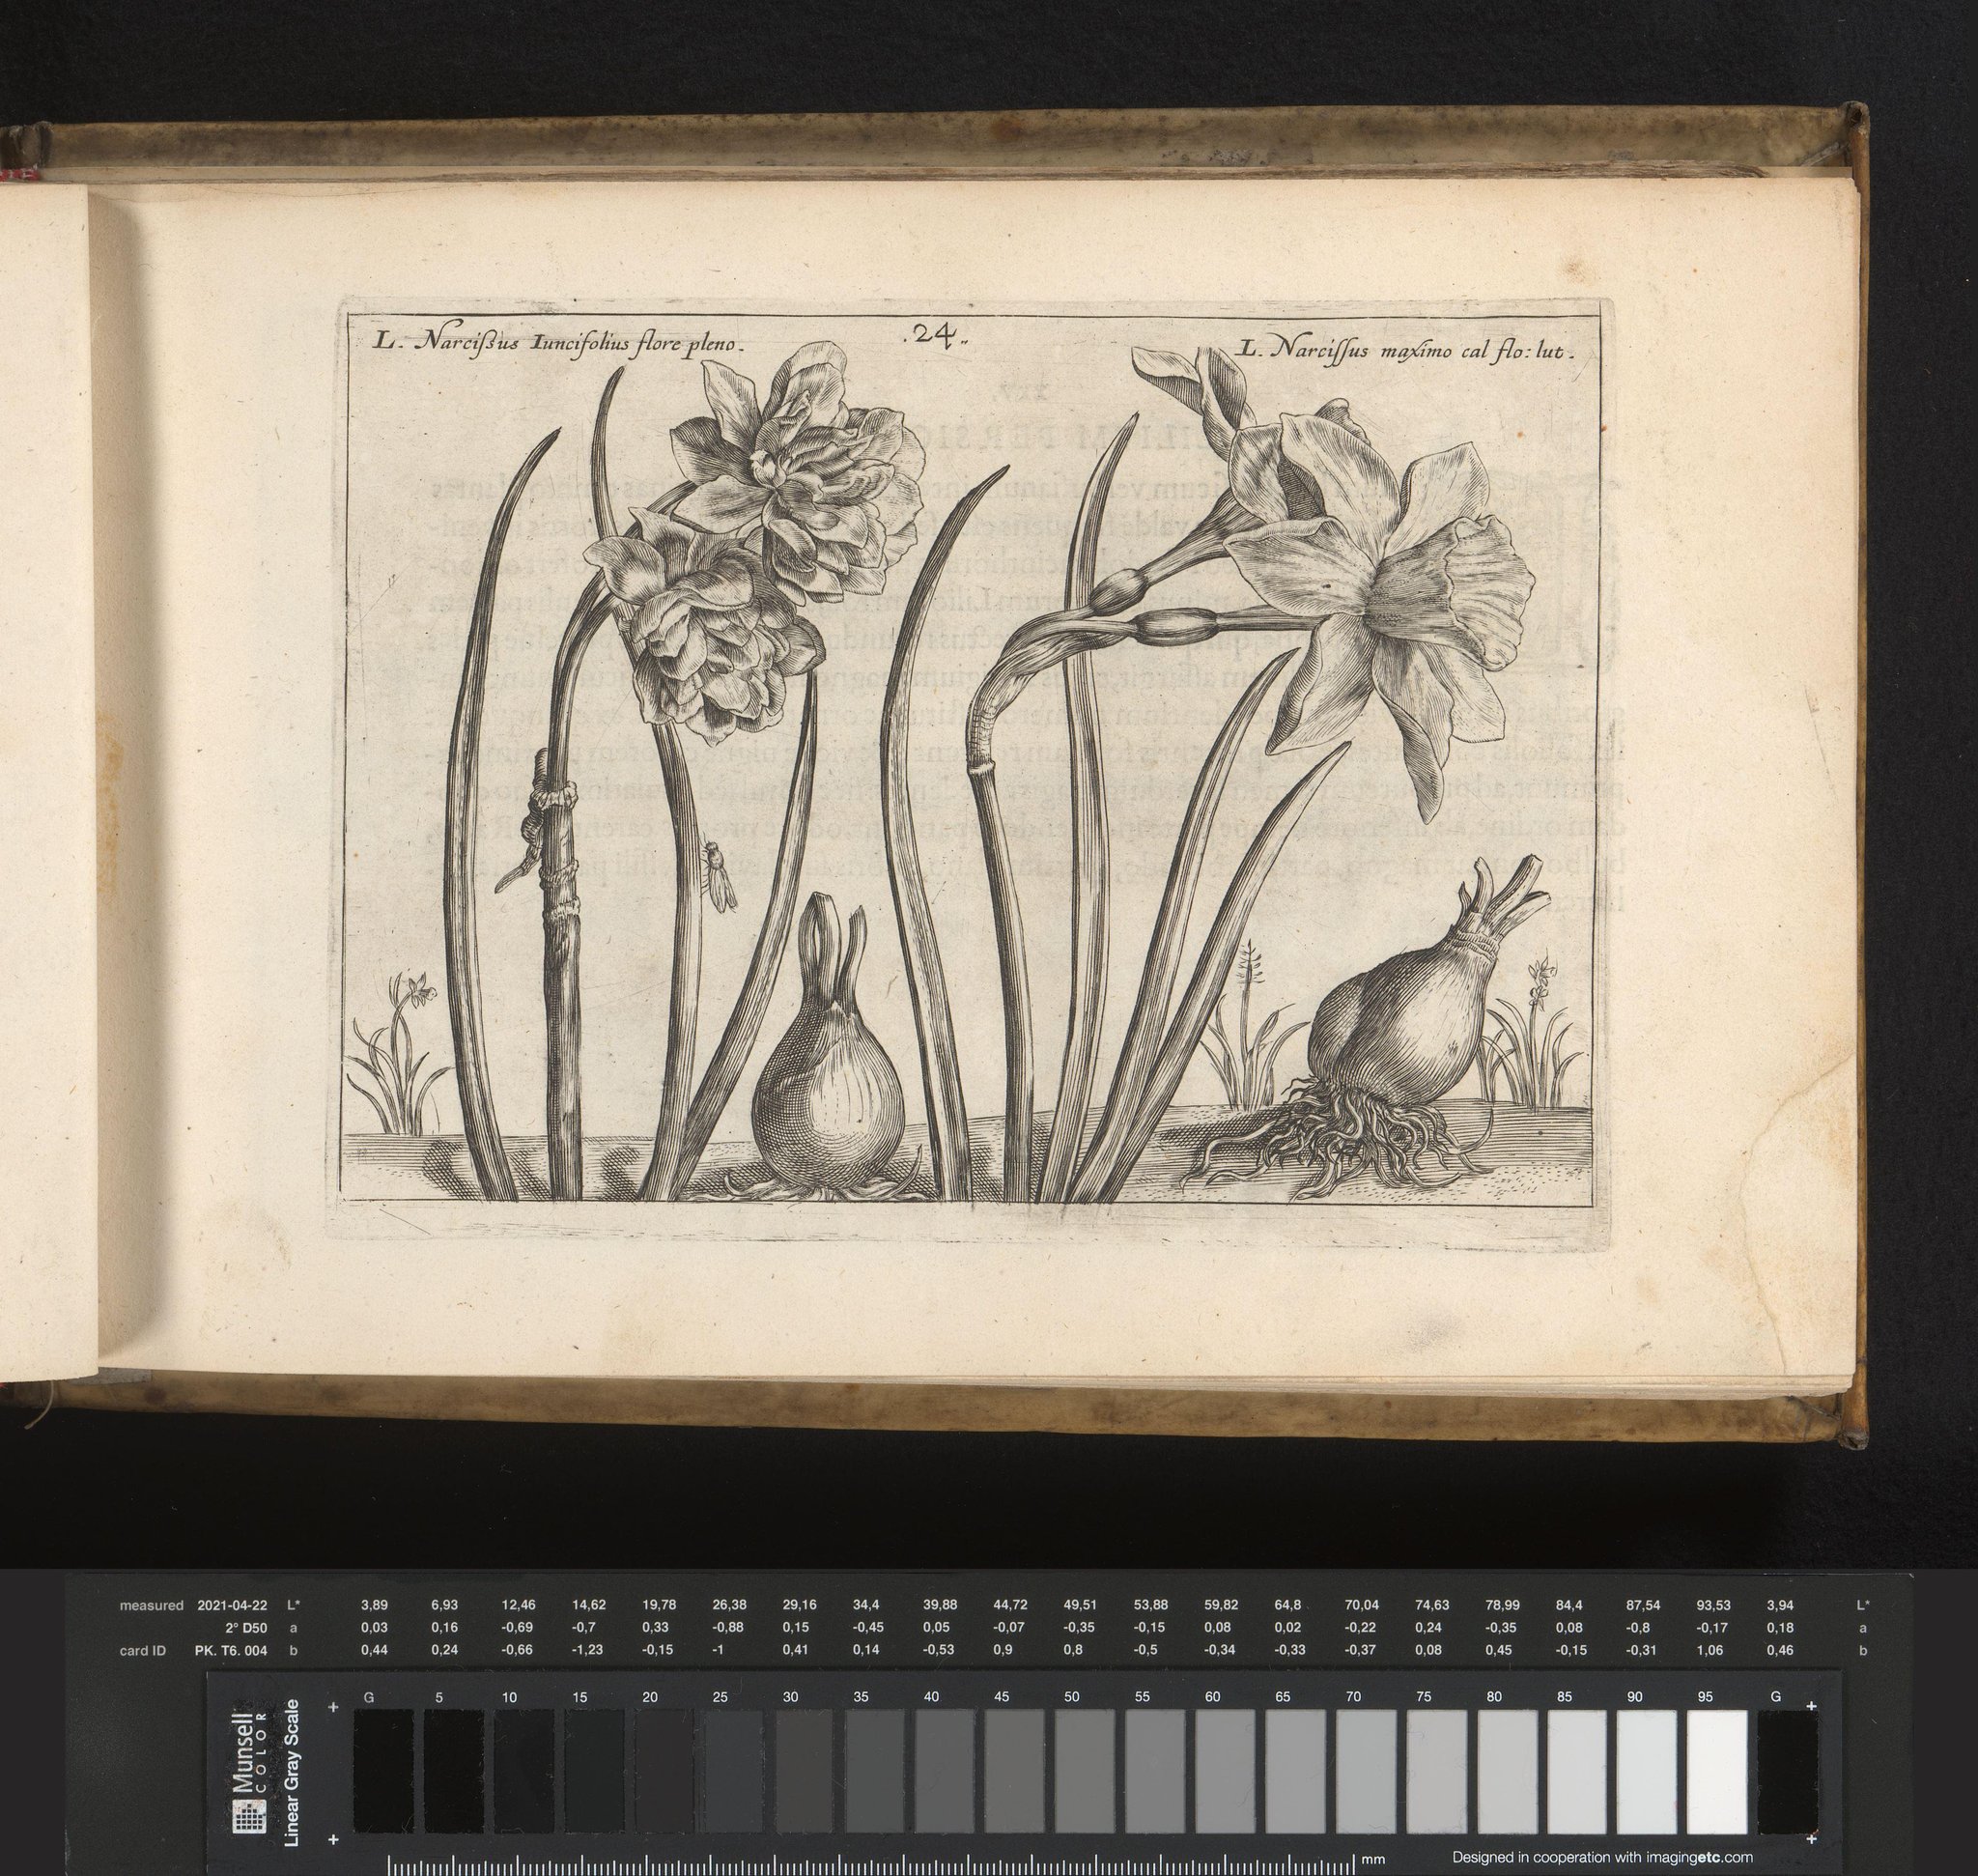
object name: book illustration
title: Bloemtuin van de lente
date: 1617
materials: paper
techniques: engraving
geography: utrecht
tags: flowers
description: Prent uit: Passe, Crispijn van de (II). Hortus floridus in quo rariorum & minus vulgarium florum icones ad vivam veramque formam. Arnhem: Johannes Janssonius, 1617.